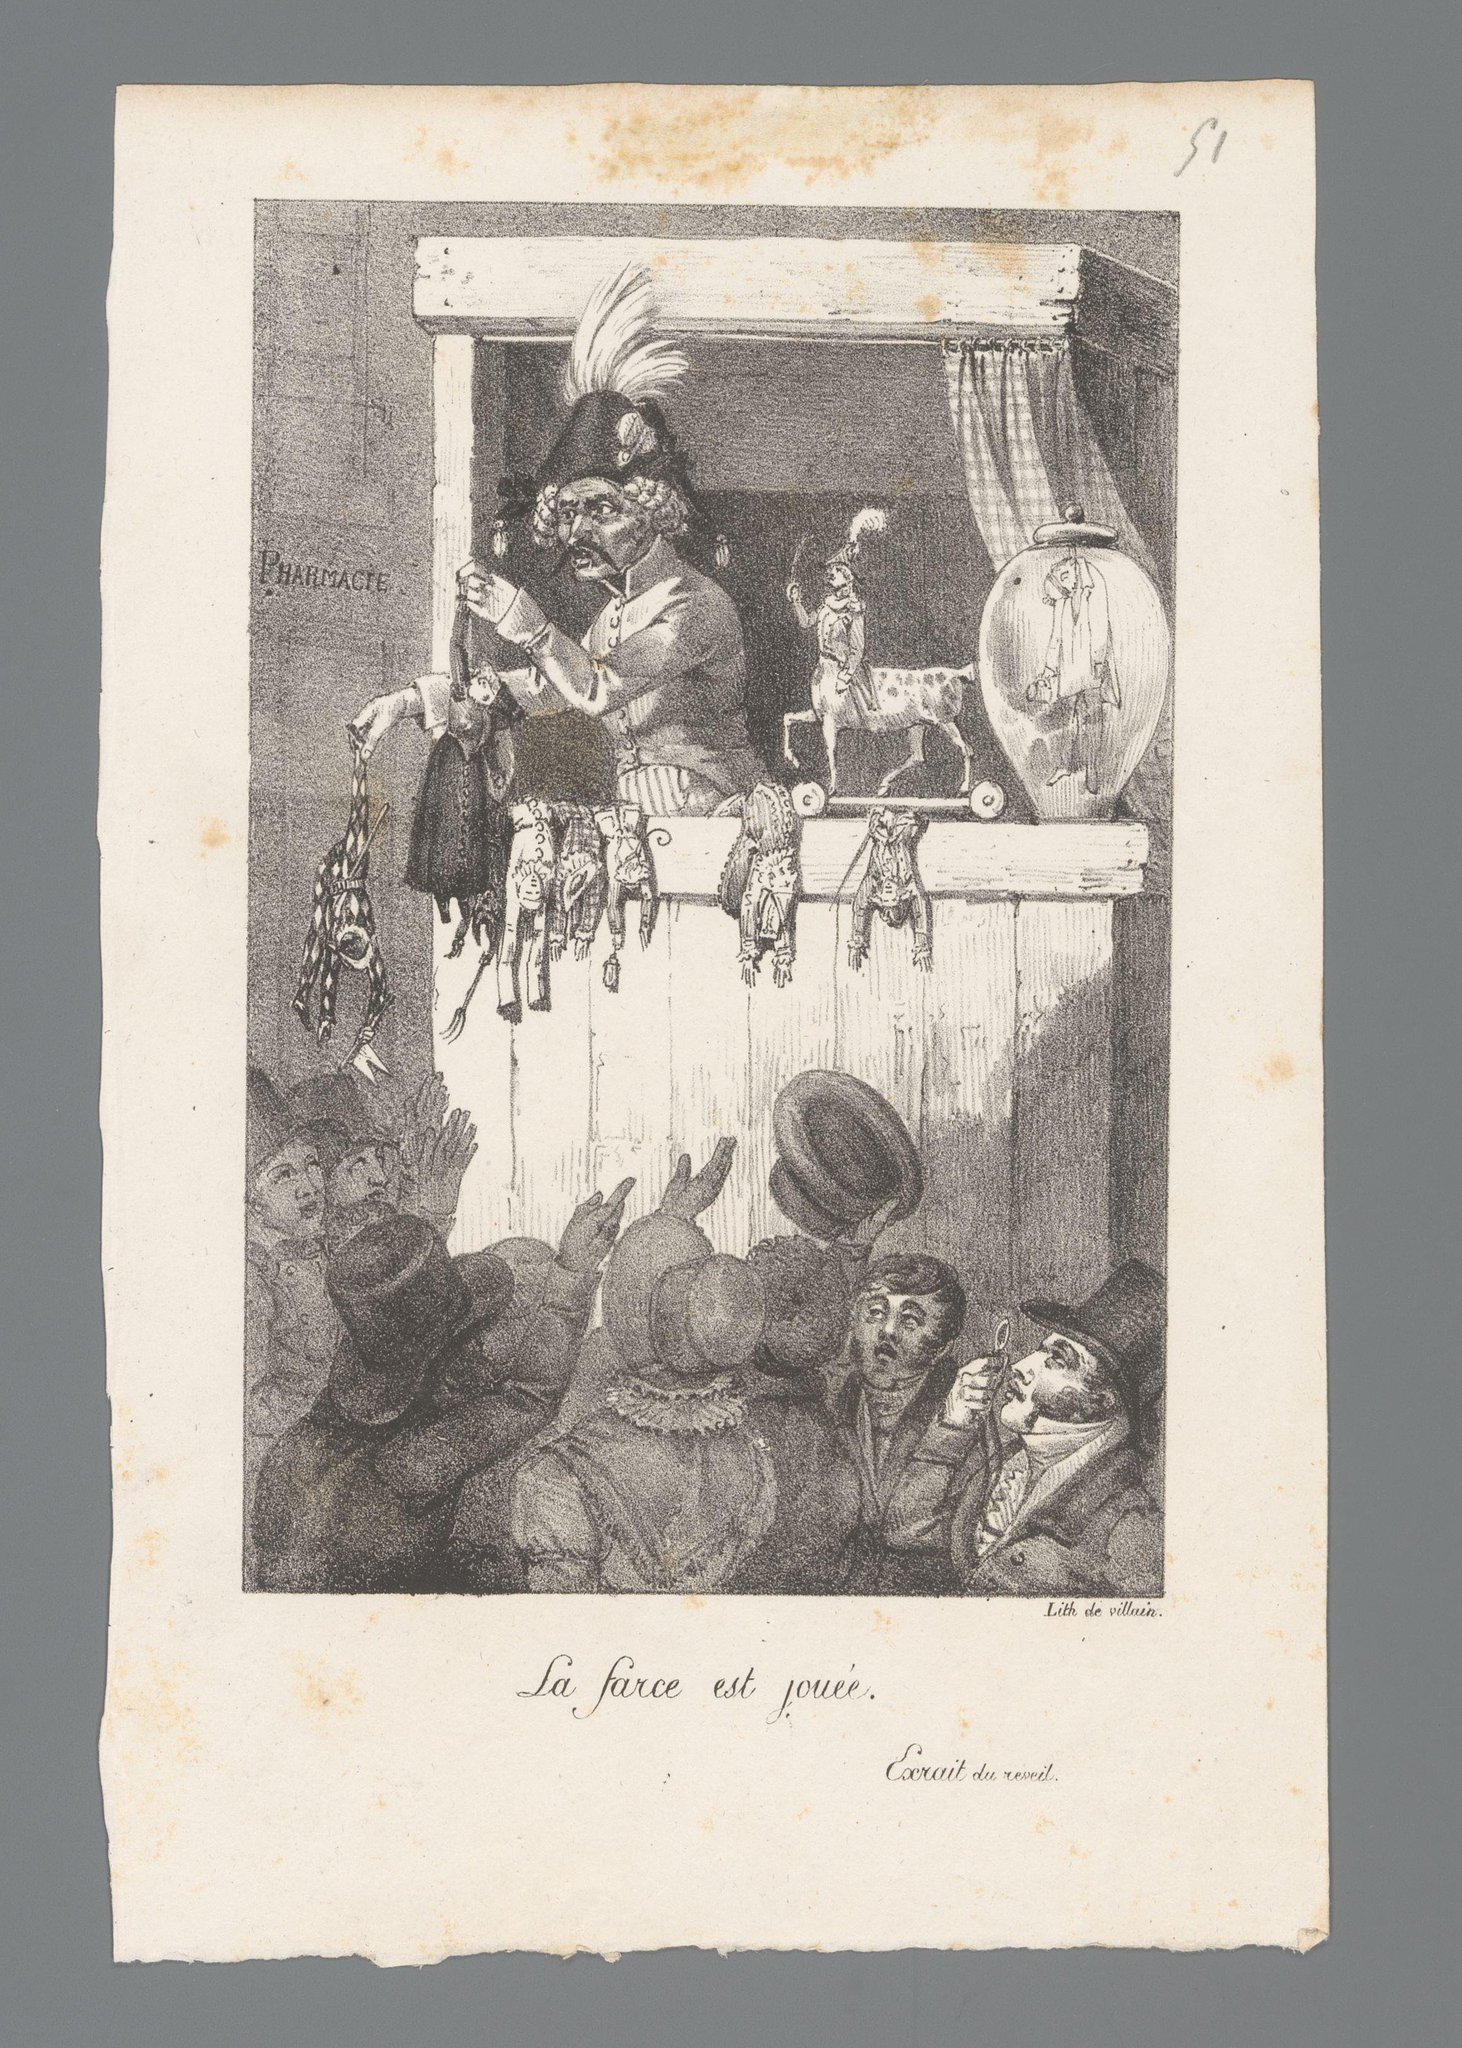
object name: cartoon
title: La farce est jouée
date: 1822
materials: paper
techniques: lithograph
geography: paris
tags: puppet and marionette show (+ artist at work)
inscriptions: collector's mark: Lugt 2228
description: Prent uit: Le Réveil, journal des sciences, de la littérature, des moeurs, théâtres et beaux-arts (1822), nr. 117, 25 november 1822.